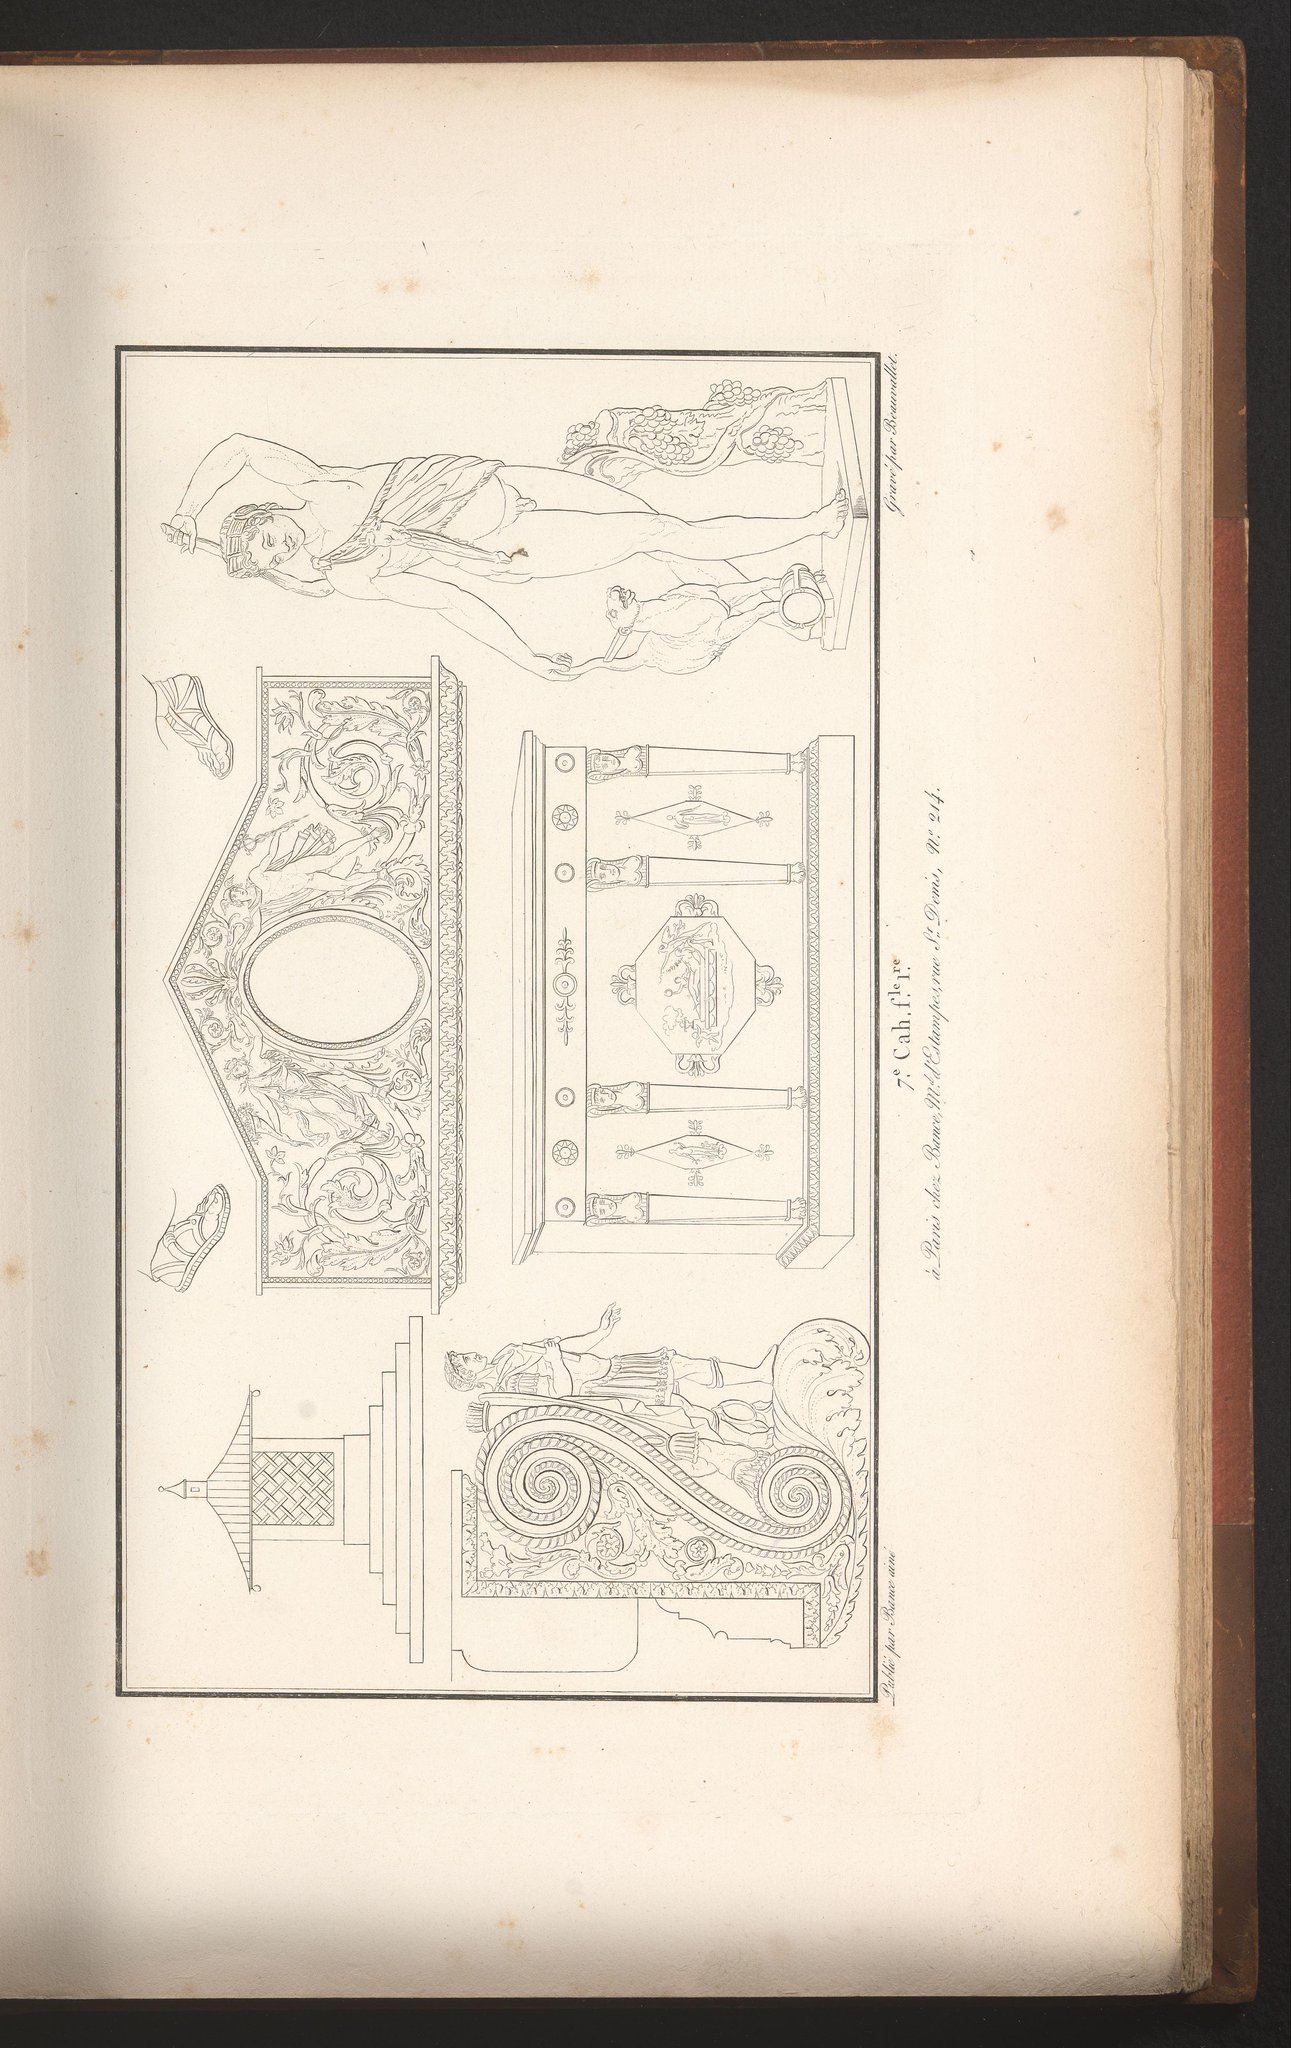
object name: ornament print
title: Verschillende ornamenten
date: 1820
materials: paper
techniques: etching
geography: paris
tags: ornaments ~ art, piece of sculpture, reproduction of a piece of sculpture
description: Ornamentprent met verschillende ornamenten, rechts een staande jongen. Onderdeel (7e. Cah. f.le 1) van het prentalbum met twee series van in totaal 138 ornamentprenten door Beauvallet en Normand, 'Fragmens d'Ornemens dans le Style Antique'.